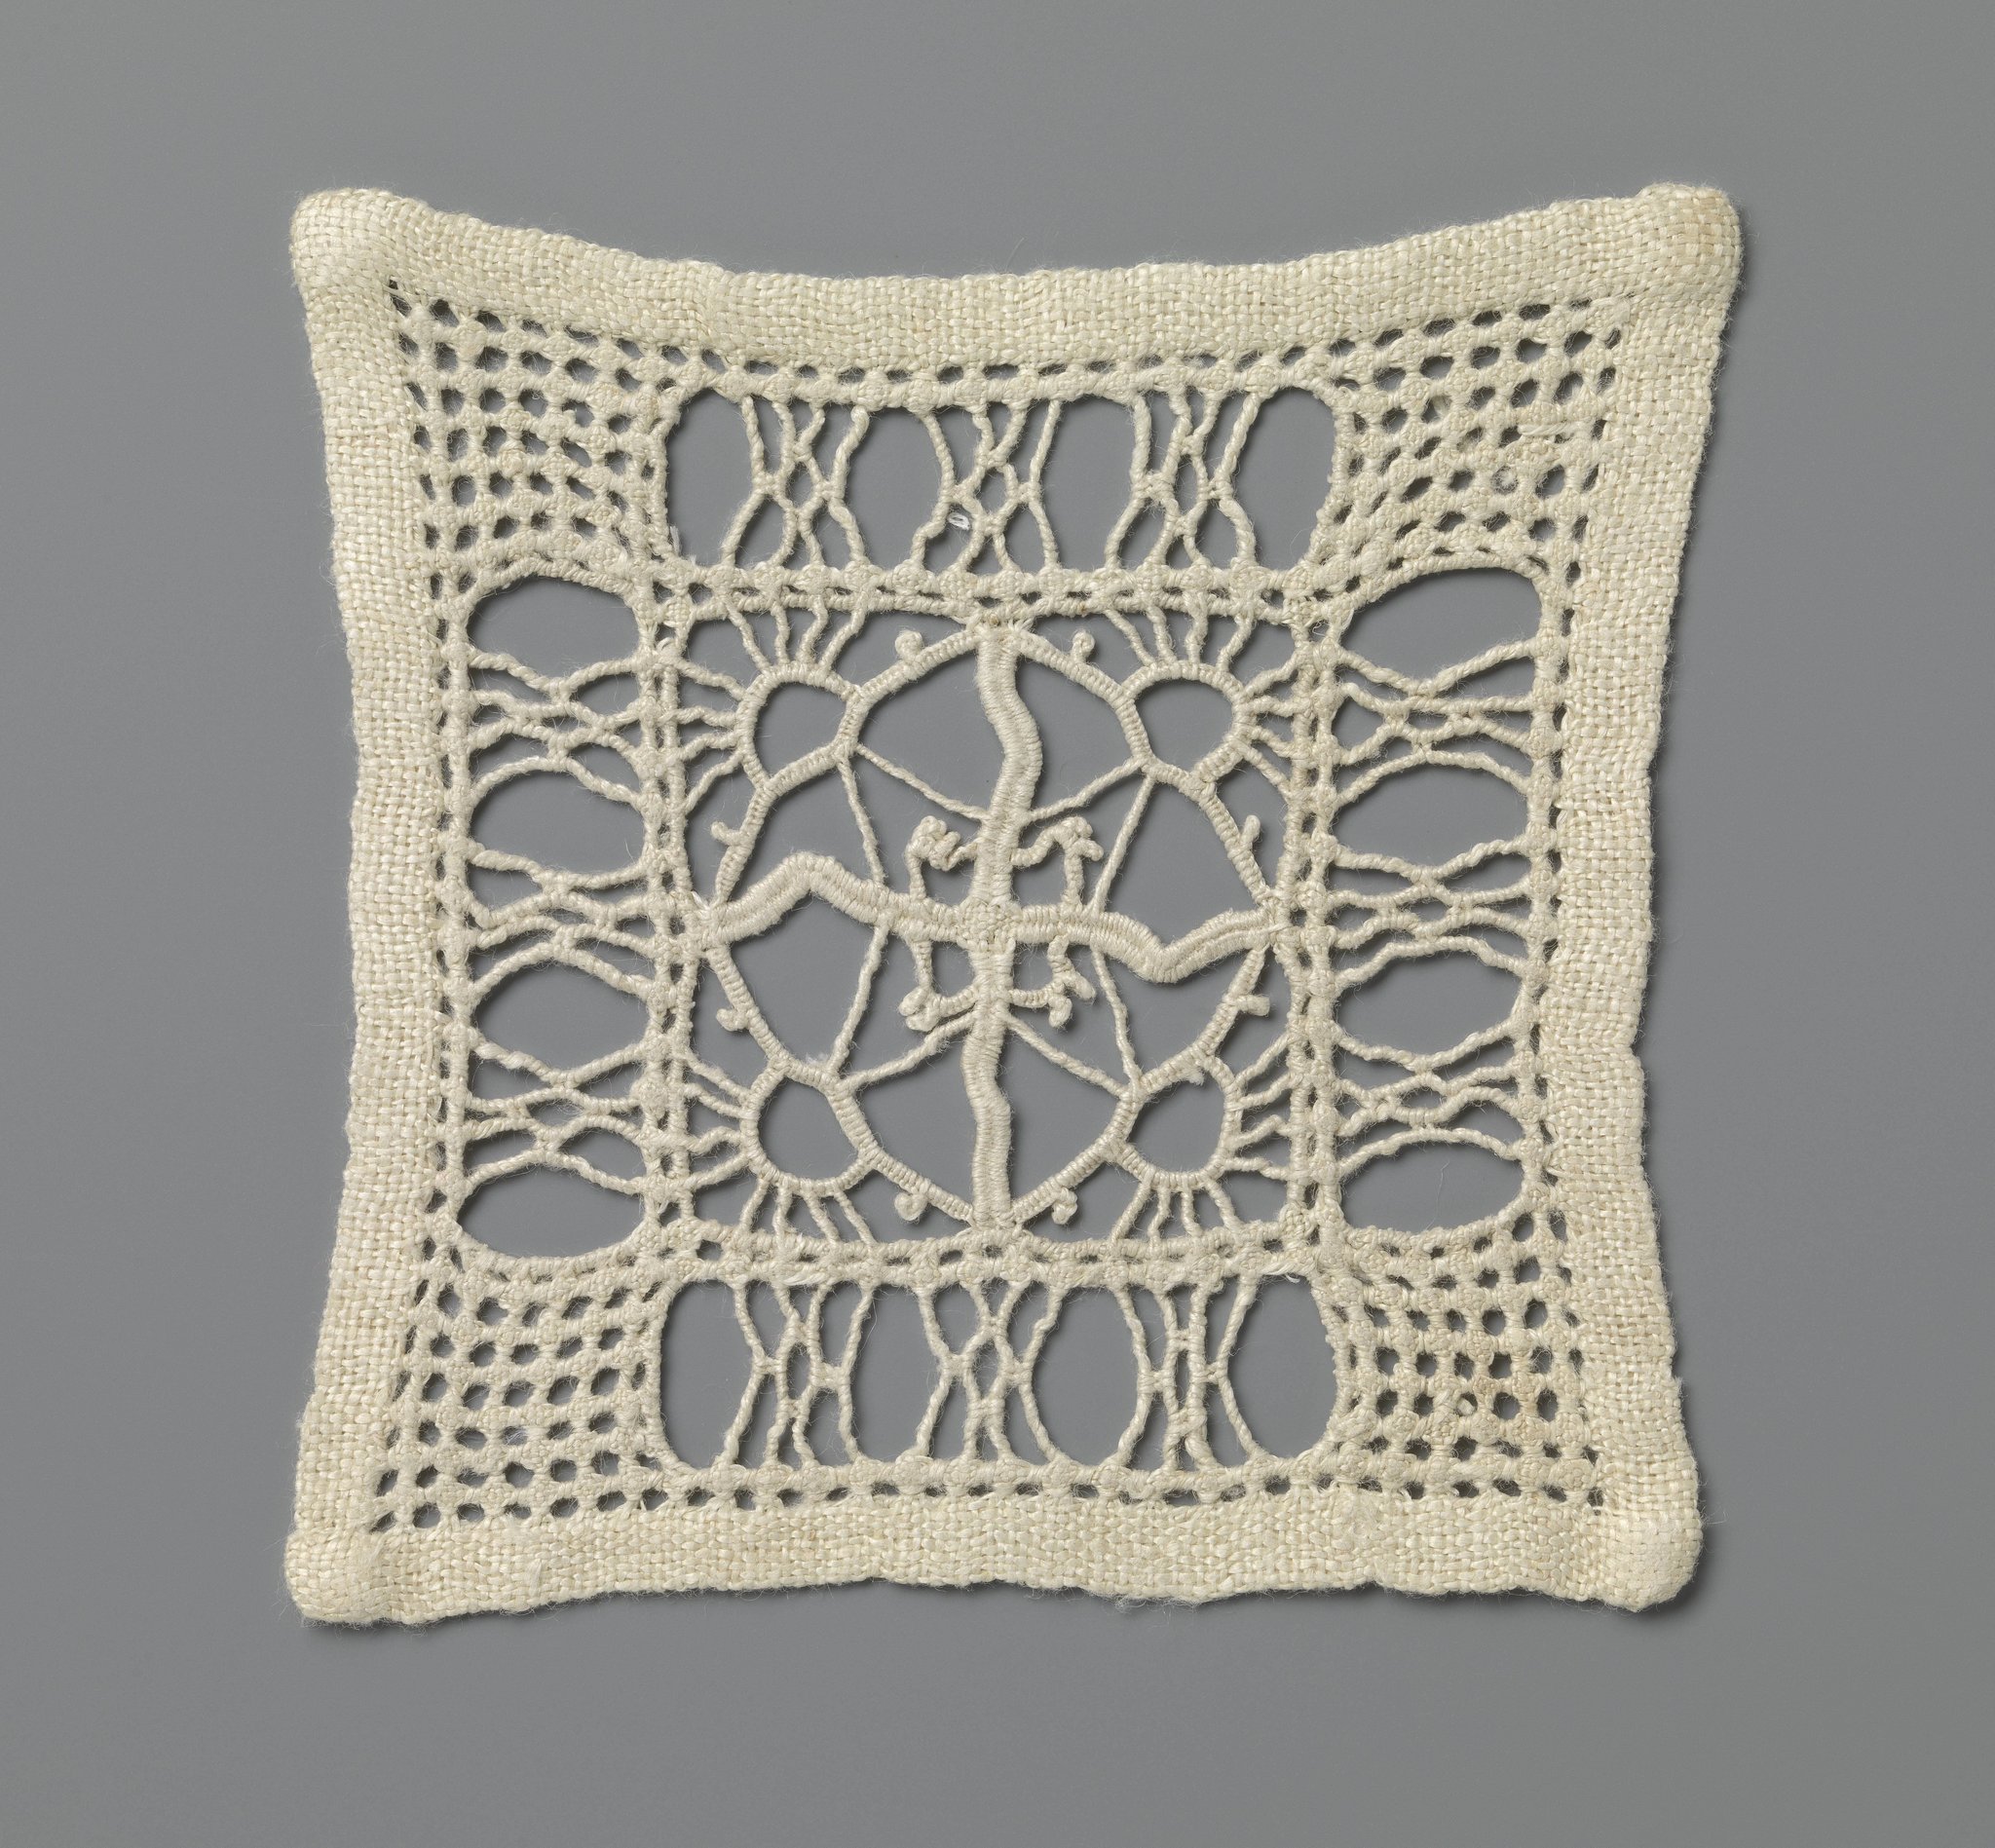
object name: mat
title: Kleedje van kantborduurwerk met opkomende zonnen langs ruitvorm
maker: Anonymous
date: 1900-1949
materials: cotton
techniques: lace embroidery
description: Vierkant kleedje van naturelkleurig kantborduurwerk, gesneden werk. Patroon met een vierkant die is opgebouwd uit vier kleine vierkanten. Elk klein vierkant is door een diagonale lijn verdeeld, met aan de buitenzijde een 'opkomende zon' en aan de binnenzijde een driehoek. Tezamen zorgt dit in het grote vierkant voor een ruitvorm met een vierpuntige ster in het midden. Om het grote vierkant aan alle zijden een rand met rechthoeken, gevuld met bundeltjes draden of met een dicht rasterwerk met opengewerkte ruitjes. Aan alle zijden een afgewerkte rand in linnenslag.